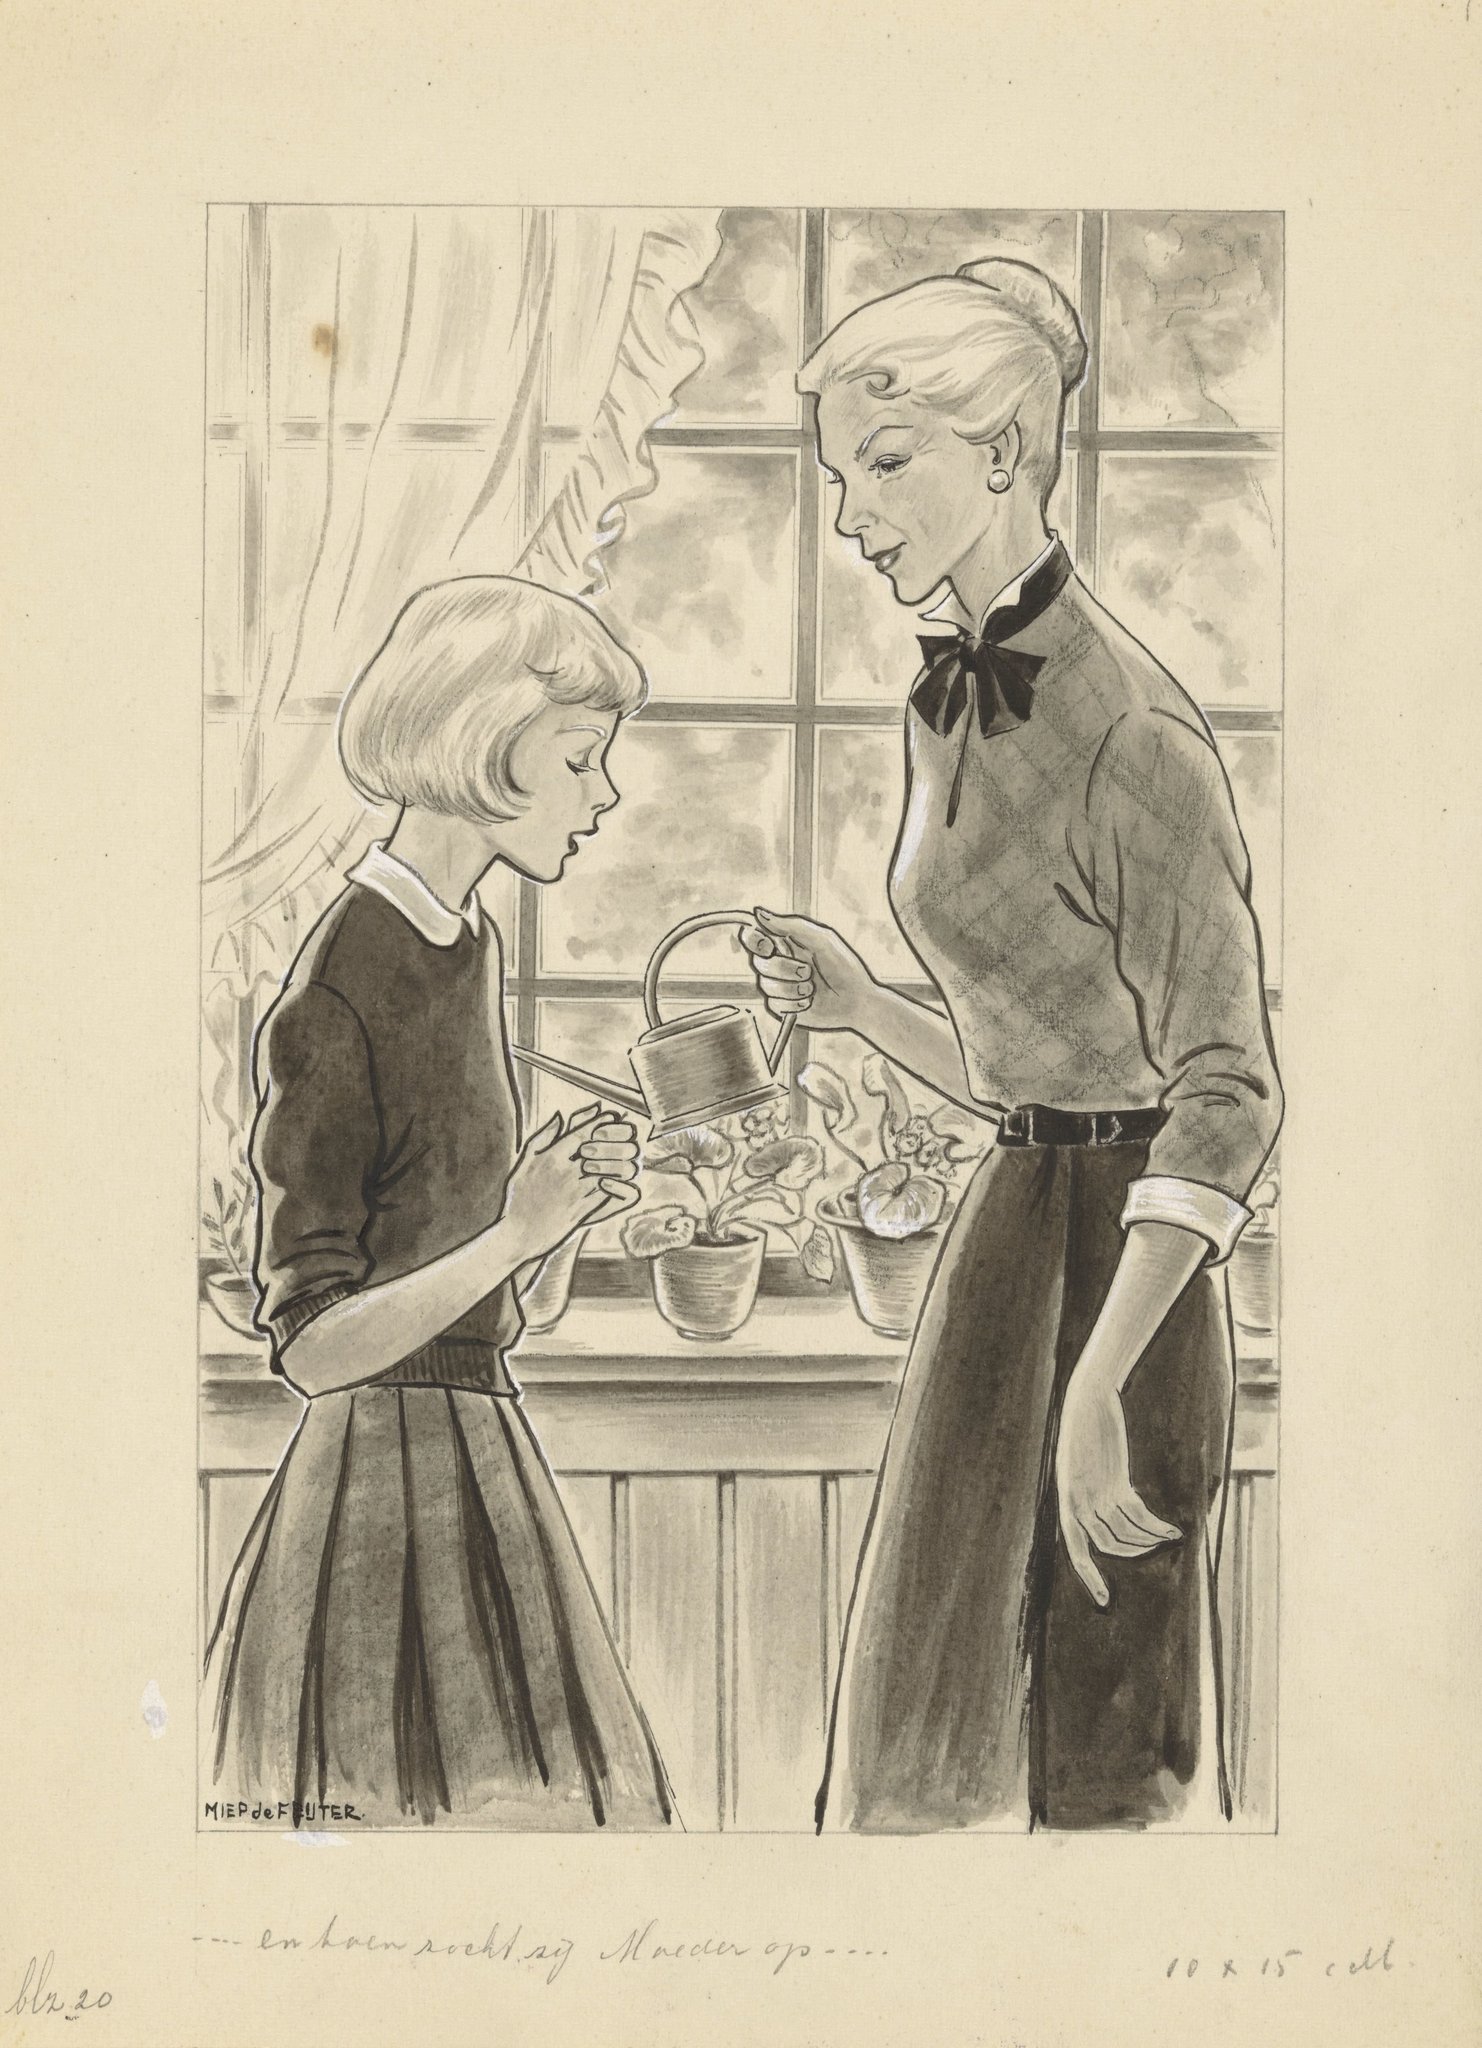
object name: boekillustratie ontwerp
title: Meisje en haar moeder bij een venster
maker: miep de feijter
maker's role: draughtsman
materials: paint, ink, paper, pencil, watercolor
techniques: brush, pen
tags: window, mother and daughter(s) (family group), potted plants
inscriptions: :, signature: ‘MIEP de FEIJTER.’, collector's mark: Lugt 2228a, annotation: ‘blz 20 .... en toen zocht zij Moeder op ....’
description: Een meisje staat tegenover haar moeder bij een venster. Moeder heeft een gieter in de hand en kijkt naar haar dochter. In de vensterbank staan planten op een rij.